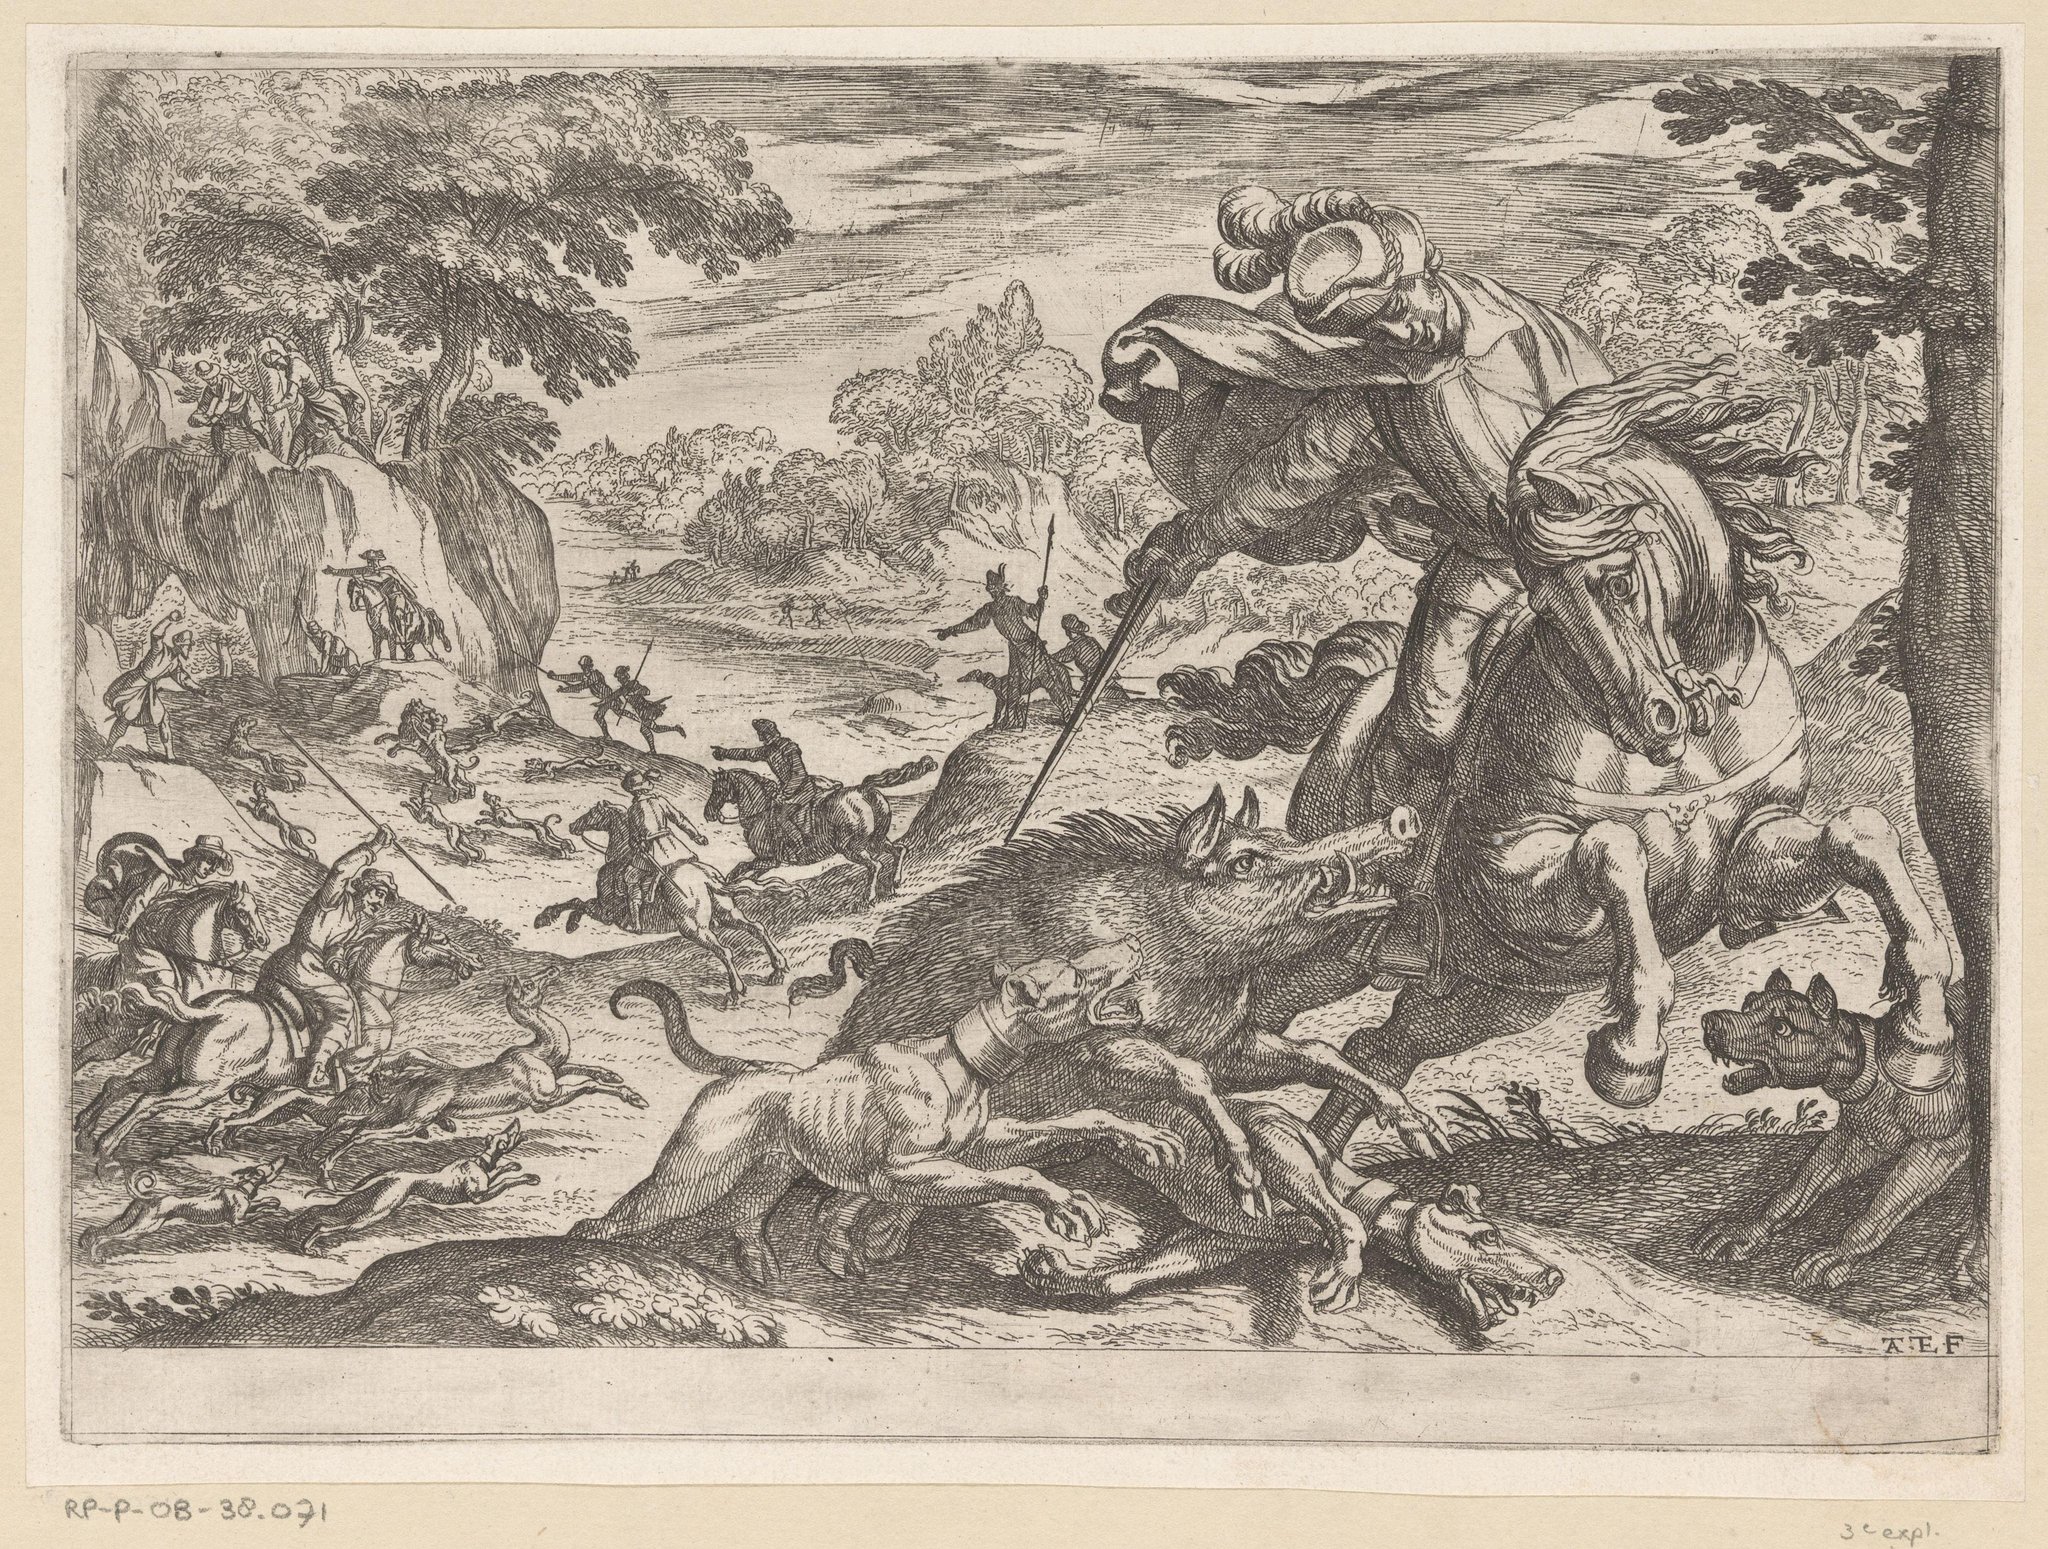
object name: print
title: Jacht op everzwijnen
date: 1608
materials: paper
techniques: etching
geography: rome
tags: boar-hunting, hunter, hunters hunting (n.b.: in 1988-1990 this notation denoted the concept of 43c11421 'hunters resting during the hunt')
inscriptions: collector's mark: Lugt 240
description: Deze prent maakt deel uit van een reeks van acht prenten (+ opdracht) met jachtscènes.